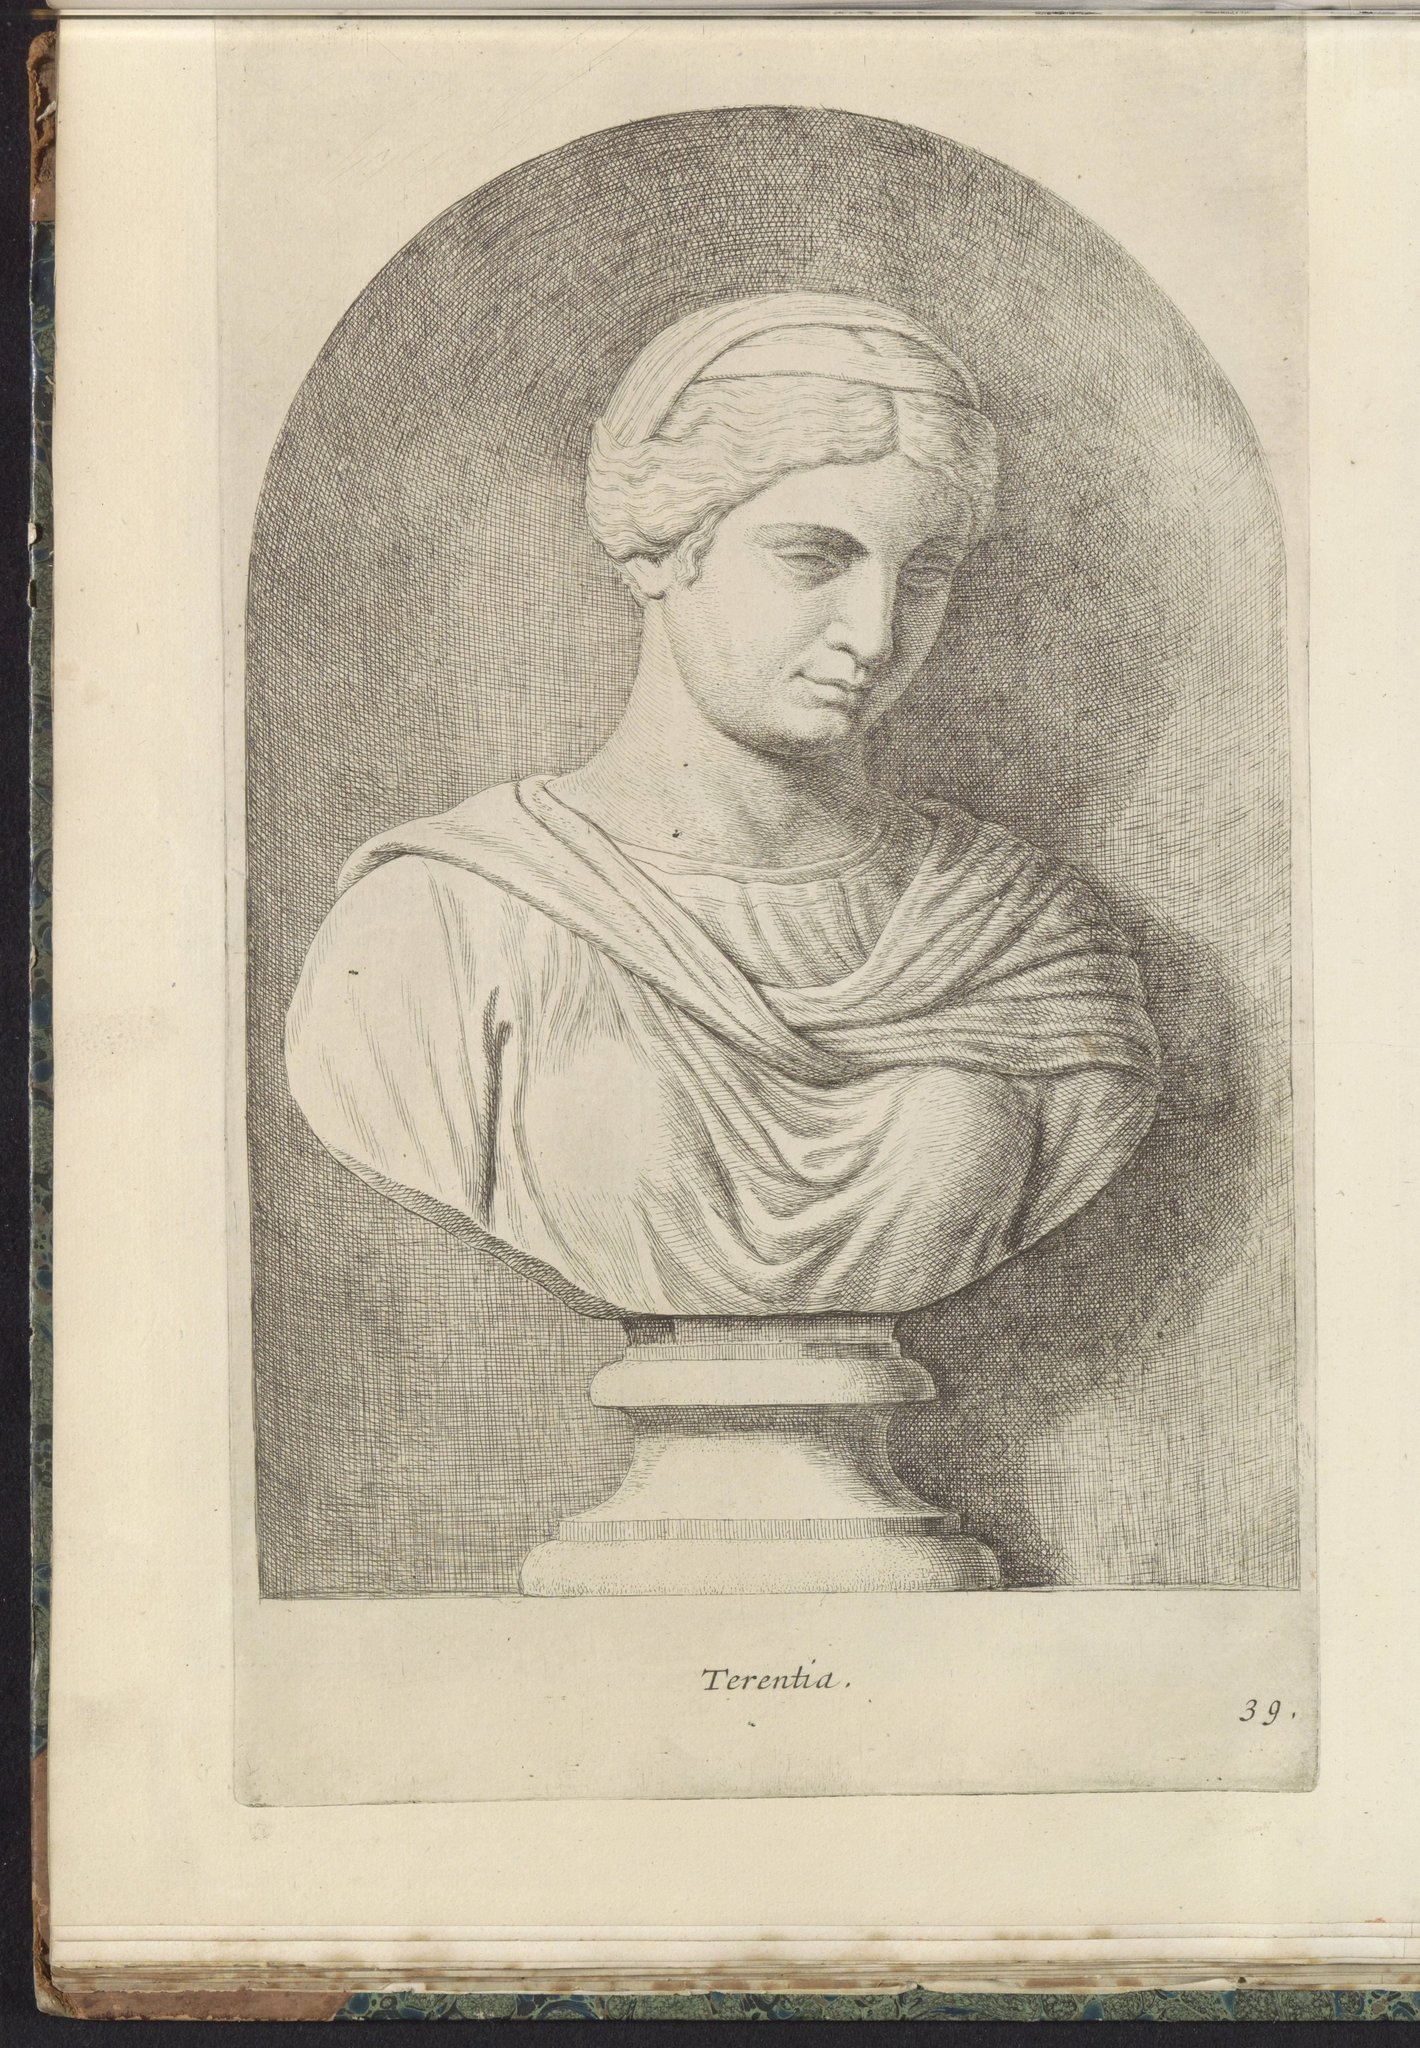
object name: album leaf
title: Buste van Terentia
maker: hubert quellinus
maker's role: print maker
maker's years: 1619-1687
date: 1646-1670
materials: paper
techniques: engraving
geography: antwerp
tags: piece of sculpture, reproduction of a piece of sculpture, female persons from classical history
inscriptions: number: ‘59’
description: Klassieke buste van een vrouw met diadeem in het haar. De prent maakt deel uit van een album met een serie prenten naar de sculpturen in de verzameling van Gerard Reynst.